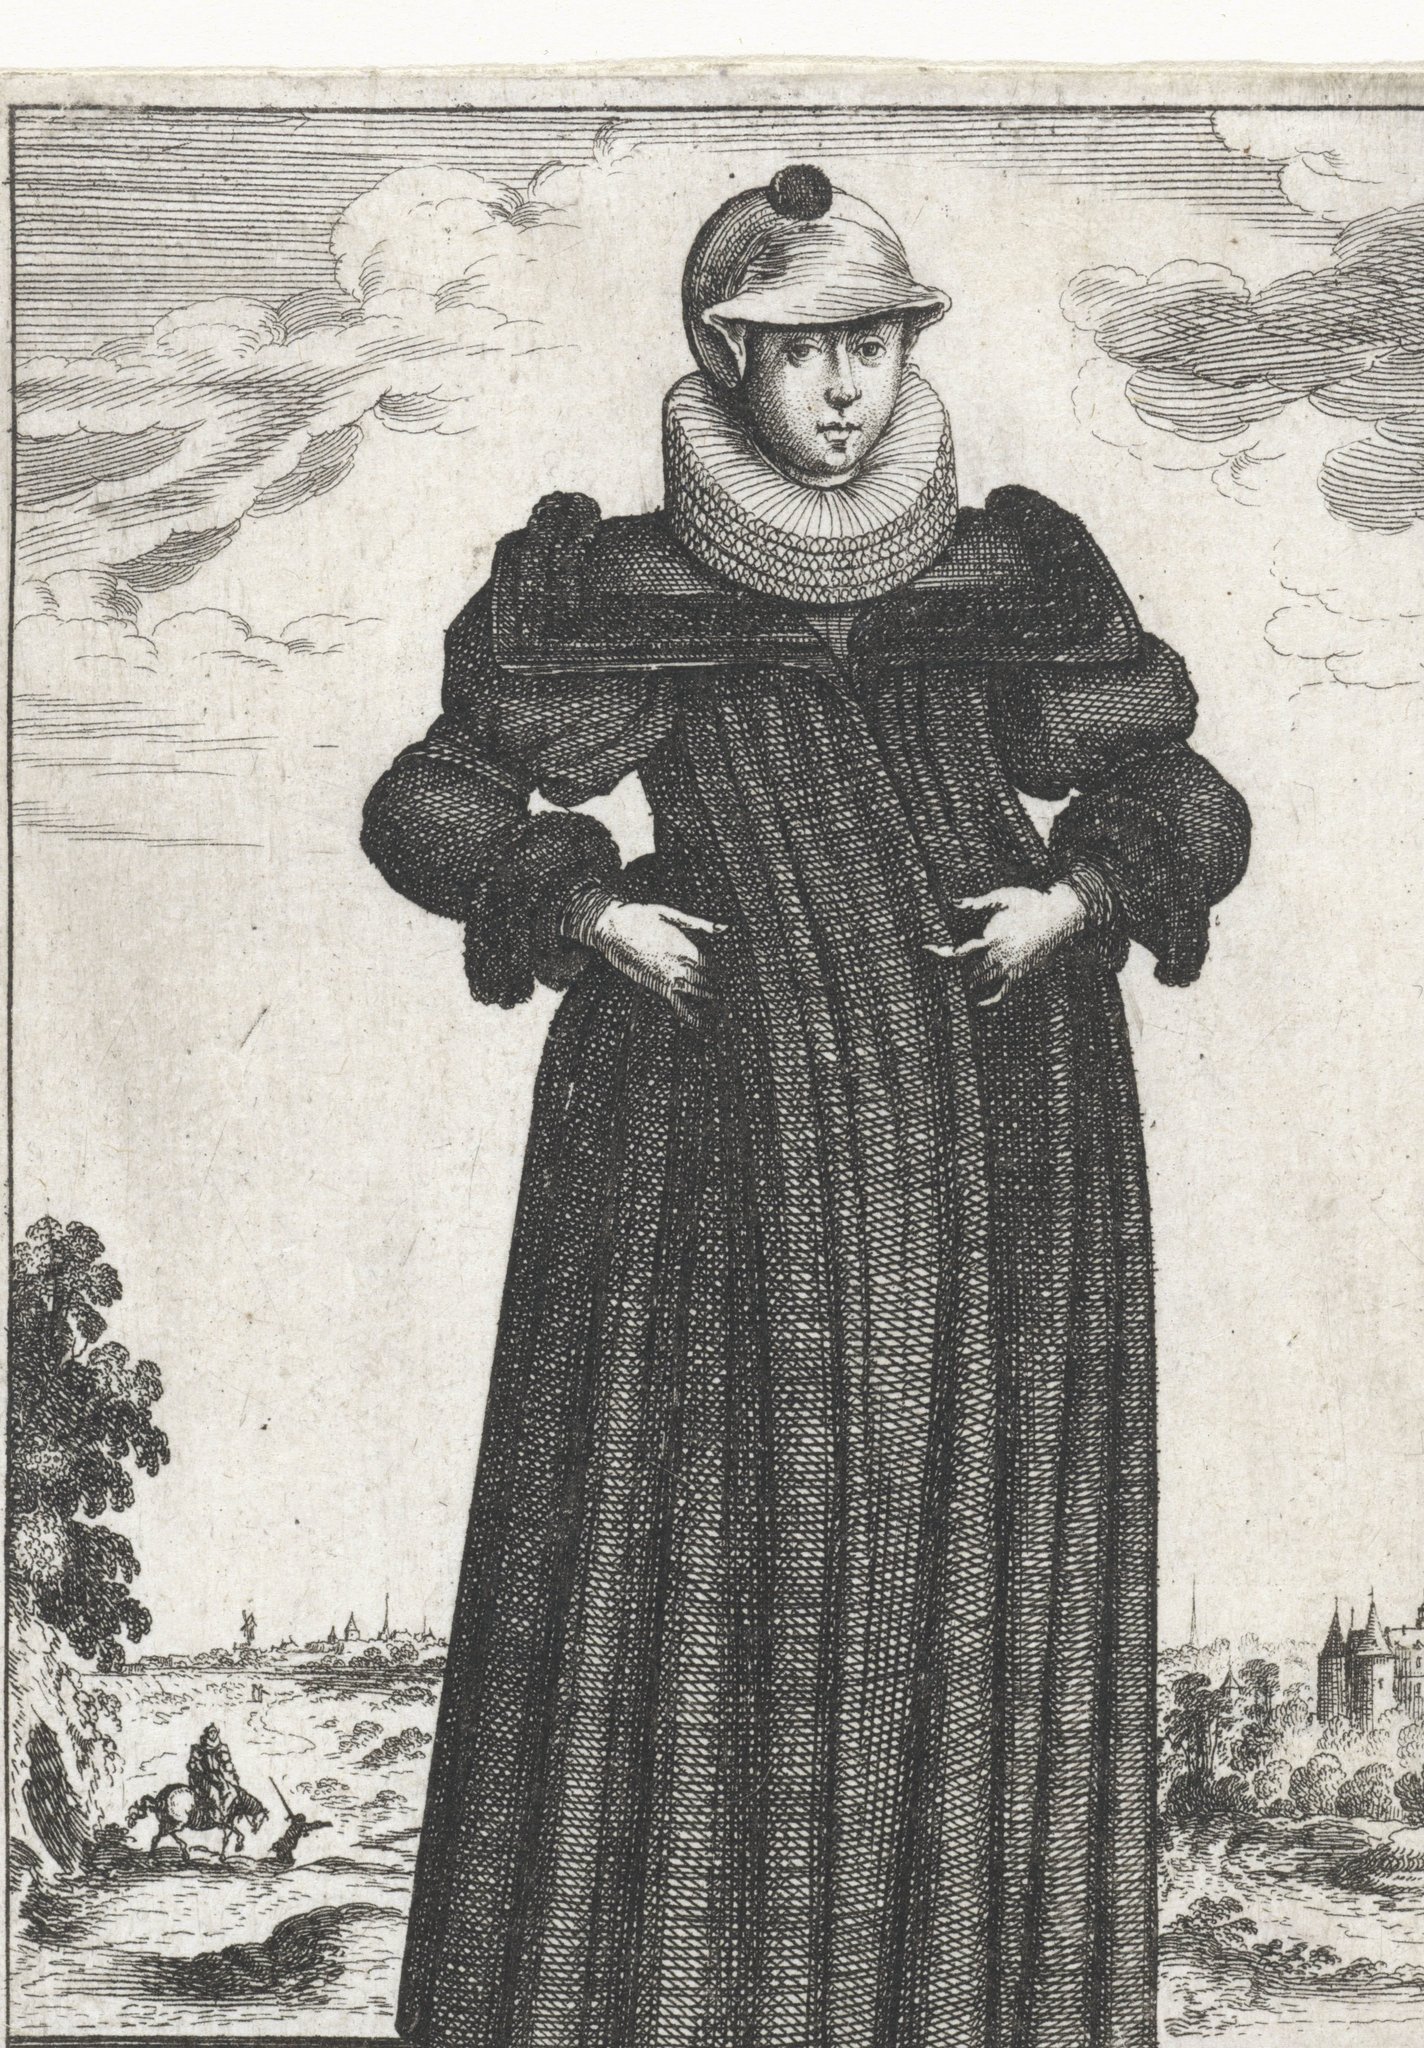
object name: costume print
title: Livre Curieux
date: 1662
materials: paper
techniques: etching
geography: paris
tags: straatsburg (frankrijk)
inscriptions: collector's mark: Lugt 240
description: Kopie naar prent die deel uitmaakt van de 50-delige serie met Europese klederdrachten, getiteld "Aula Veneris".. De prent maakt deel uit van de 28-delige serie (excl. titelprent) met voorstellingen van vrouwen in verschillende klederdrachten, getiteld "Livre curieux contenant la naifue representations des habits des femmes des diverses parties du Monde (...), 1662".